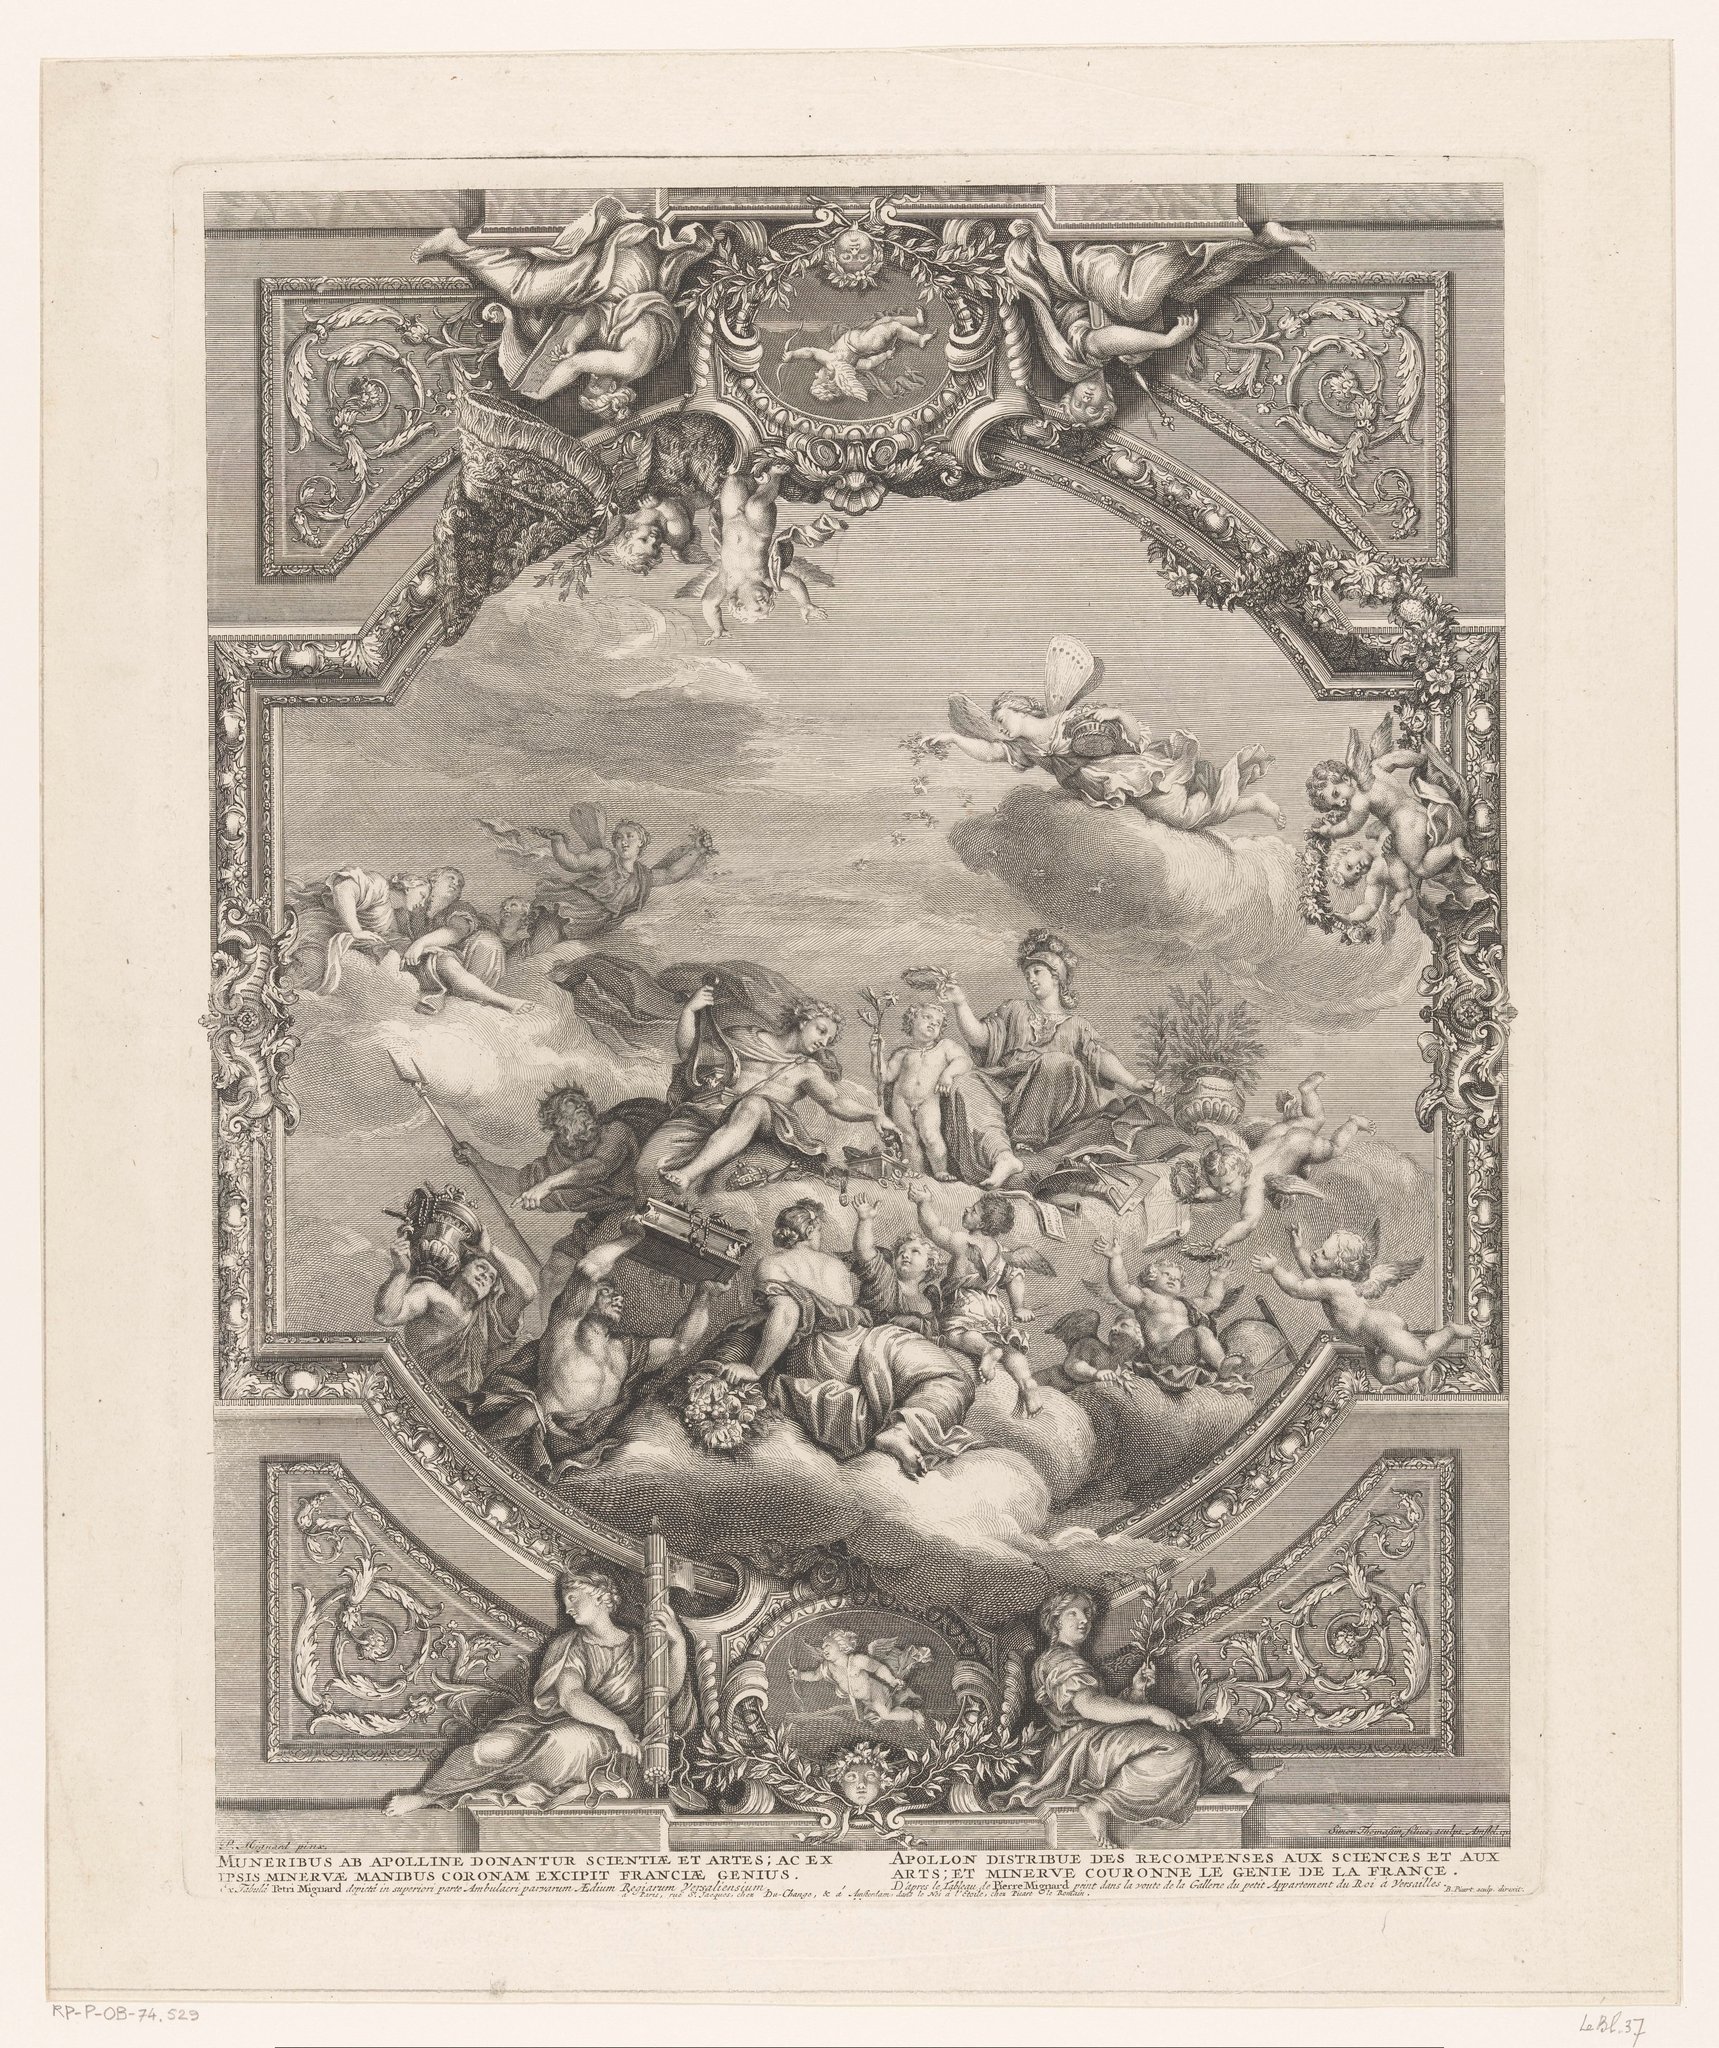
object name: print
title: Plafondschildering in Versailles: Apollo deelt beloningen uit aan Kunsten en Wetenschappen, Minerva kroont het genie van Frankrijk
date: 1711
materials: paper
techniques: engraving, etching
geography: paris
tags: the liberal arts together with other disciplines, specific aspects, allegorical aspects of minerva; minerva as patroness - veneration, honoured by, specific aspects, allegorical aspects of apollo; apollo as patron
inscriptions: number: ‘248’, collector's mark: Lugt 240